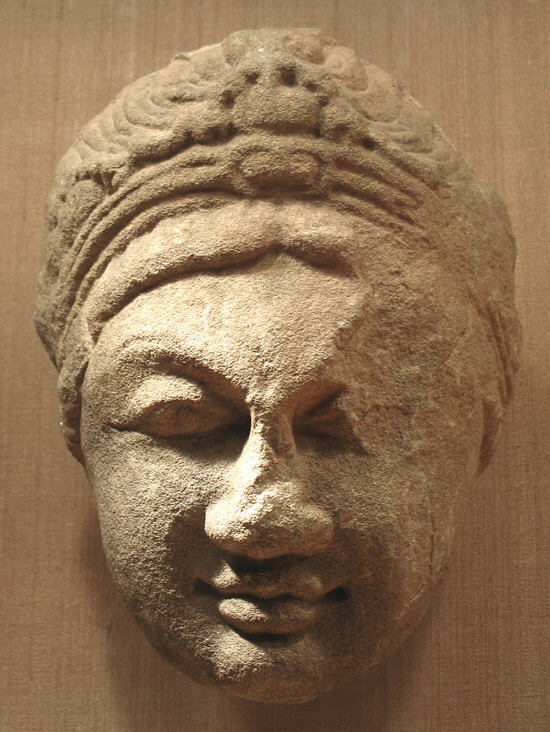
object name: head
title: Head of an Unidentified Deity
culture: indian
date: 701-900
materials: stone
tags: heads